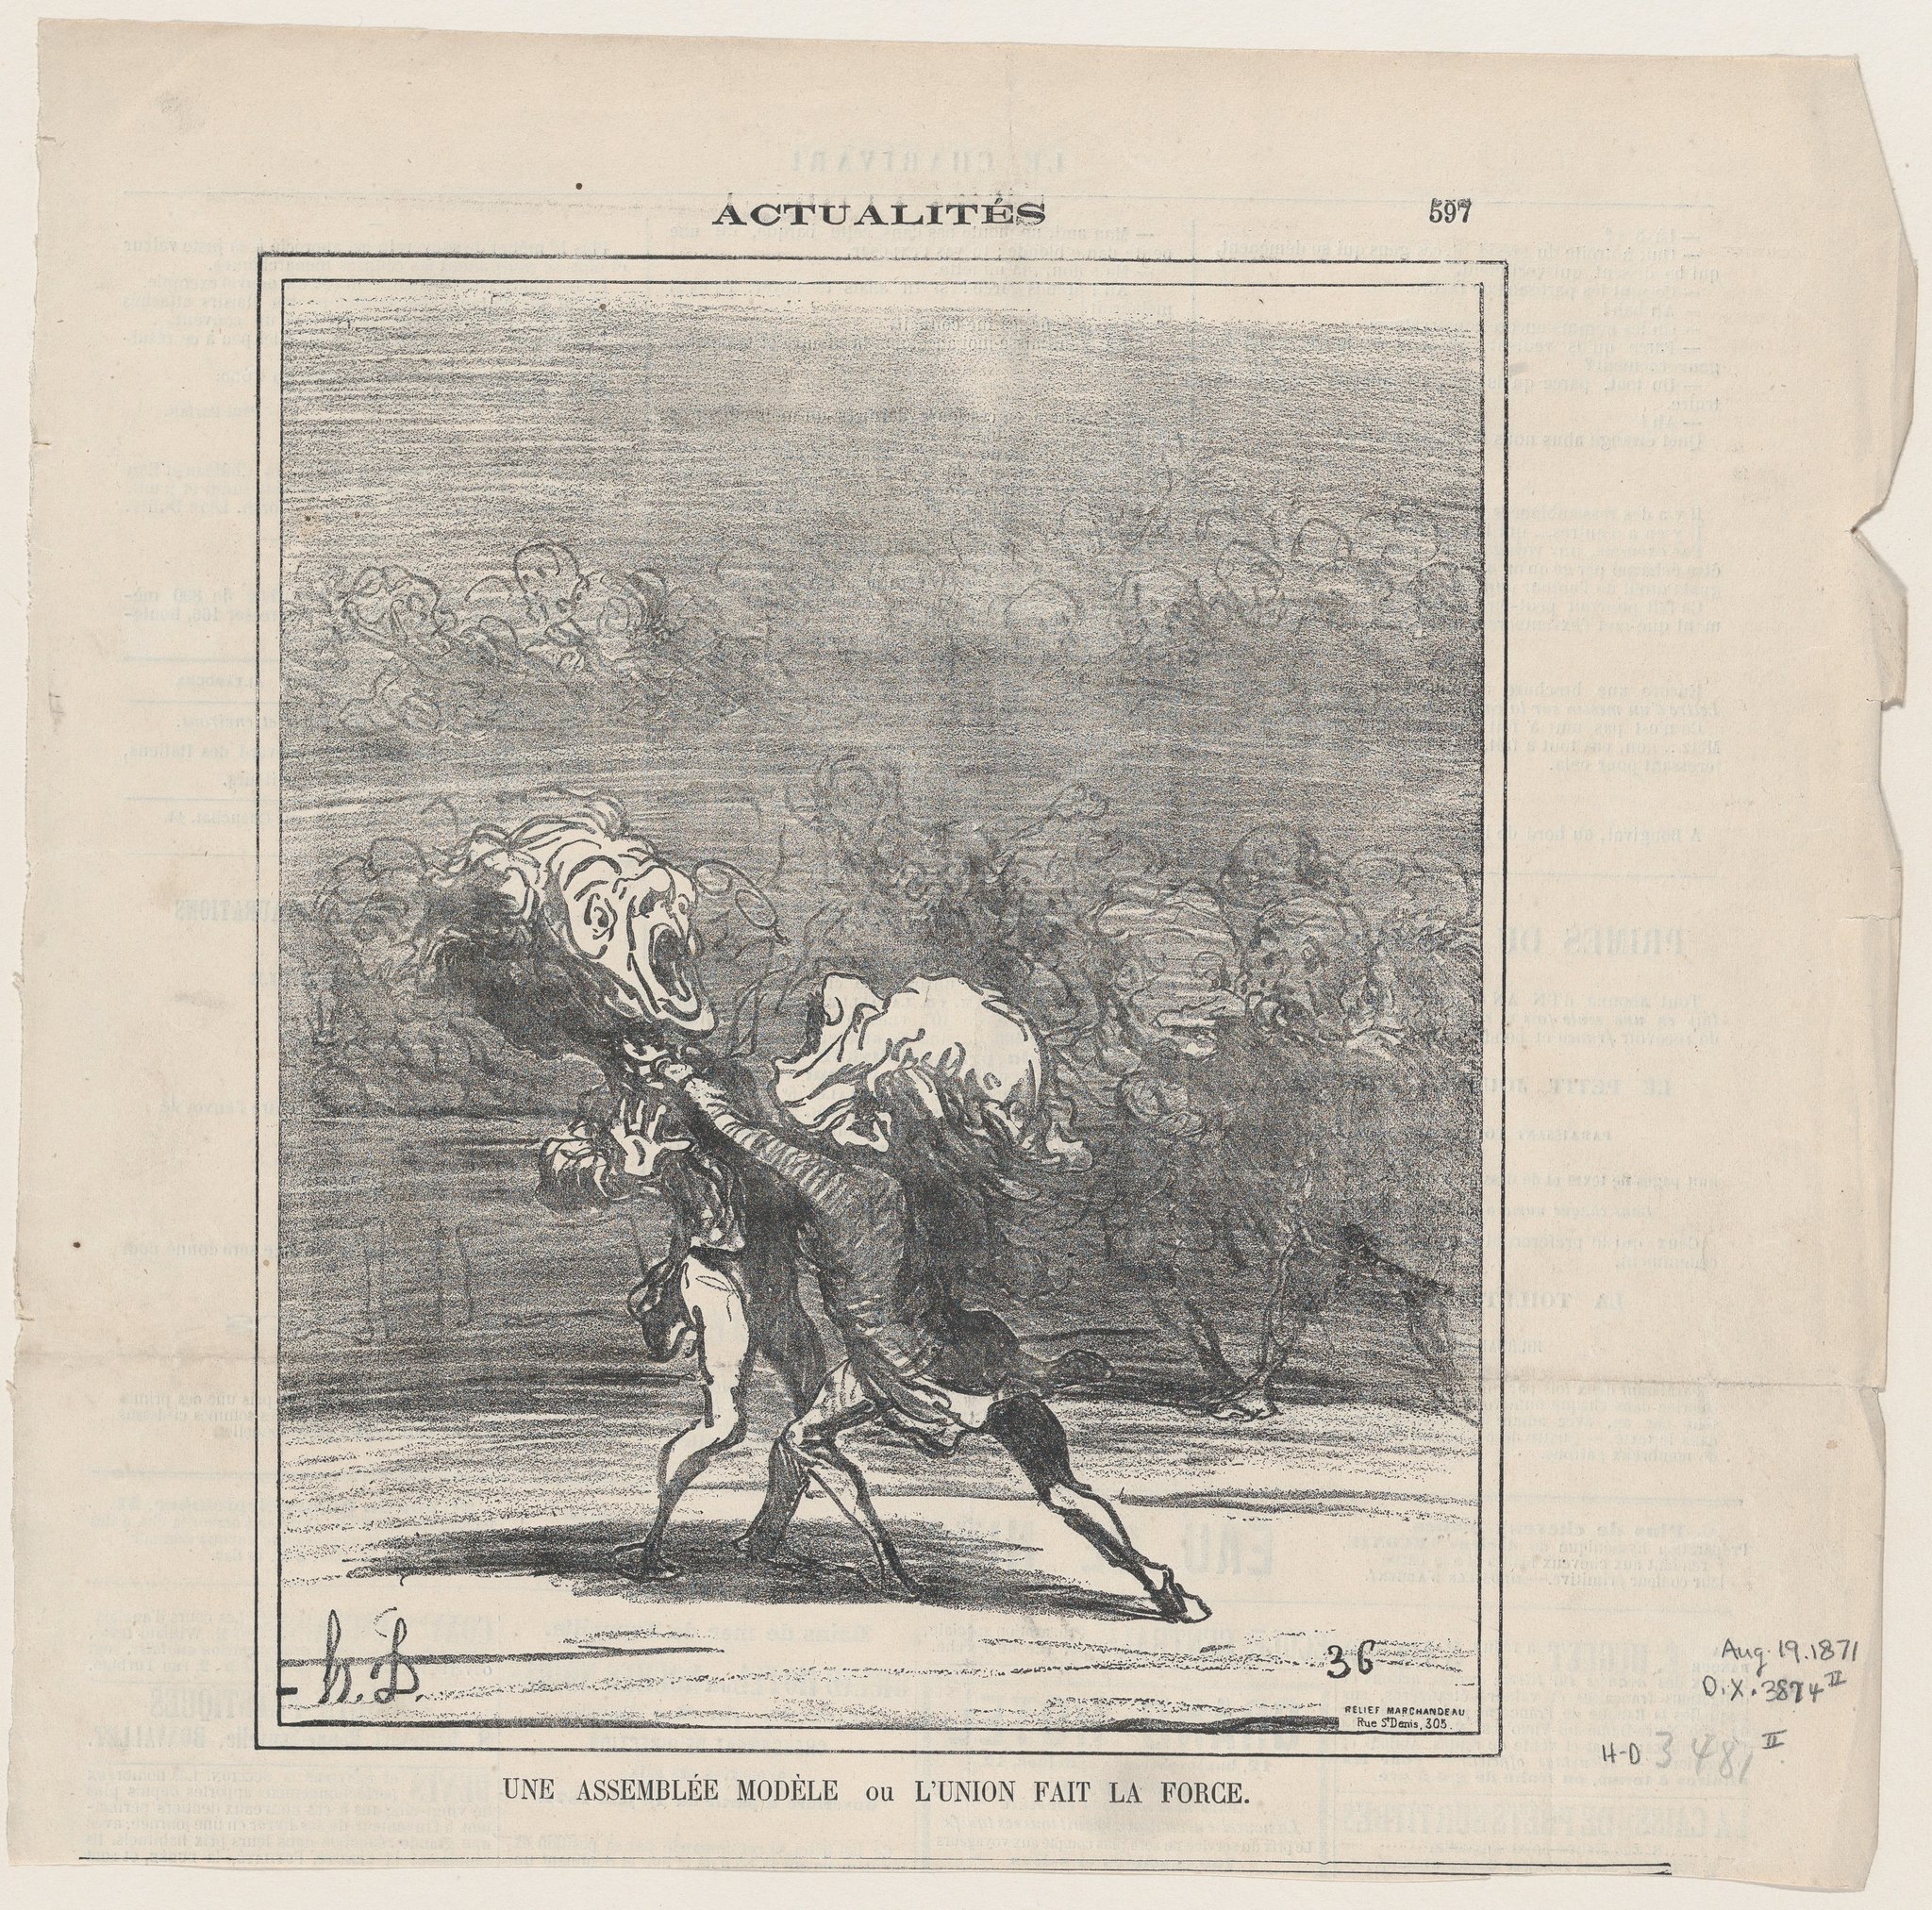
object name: print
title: A model of an assembly or unity makes strength, from 'News of the day,' published in Le Charivari, August 19, 1871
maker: honoré daumier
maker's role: artist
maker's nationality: french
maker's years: 1808-1879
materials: paper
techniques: lithograph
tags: satire,men